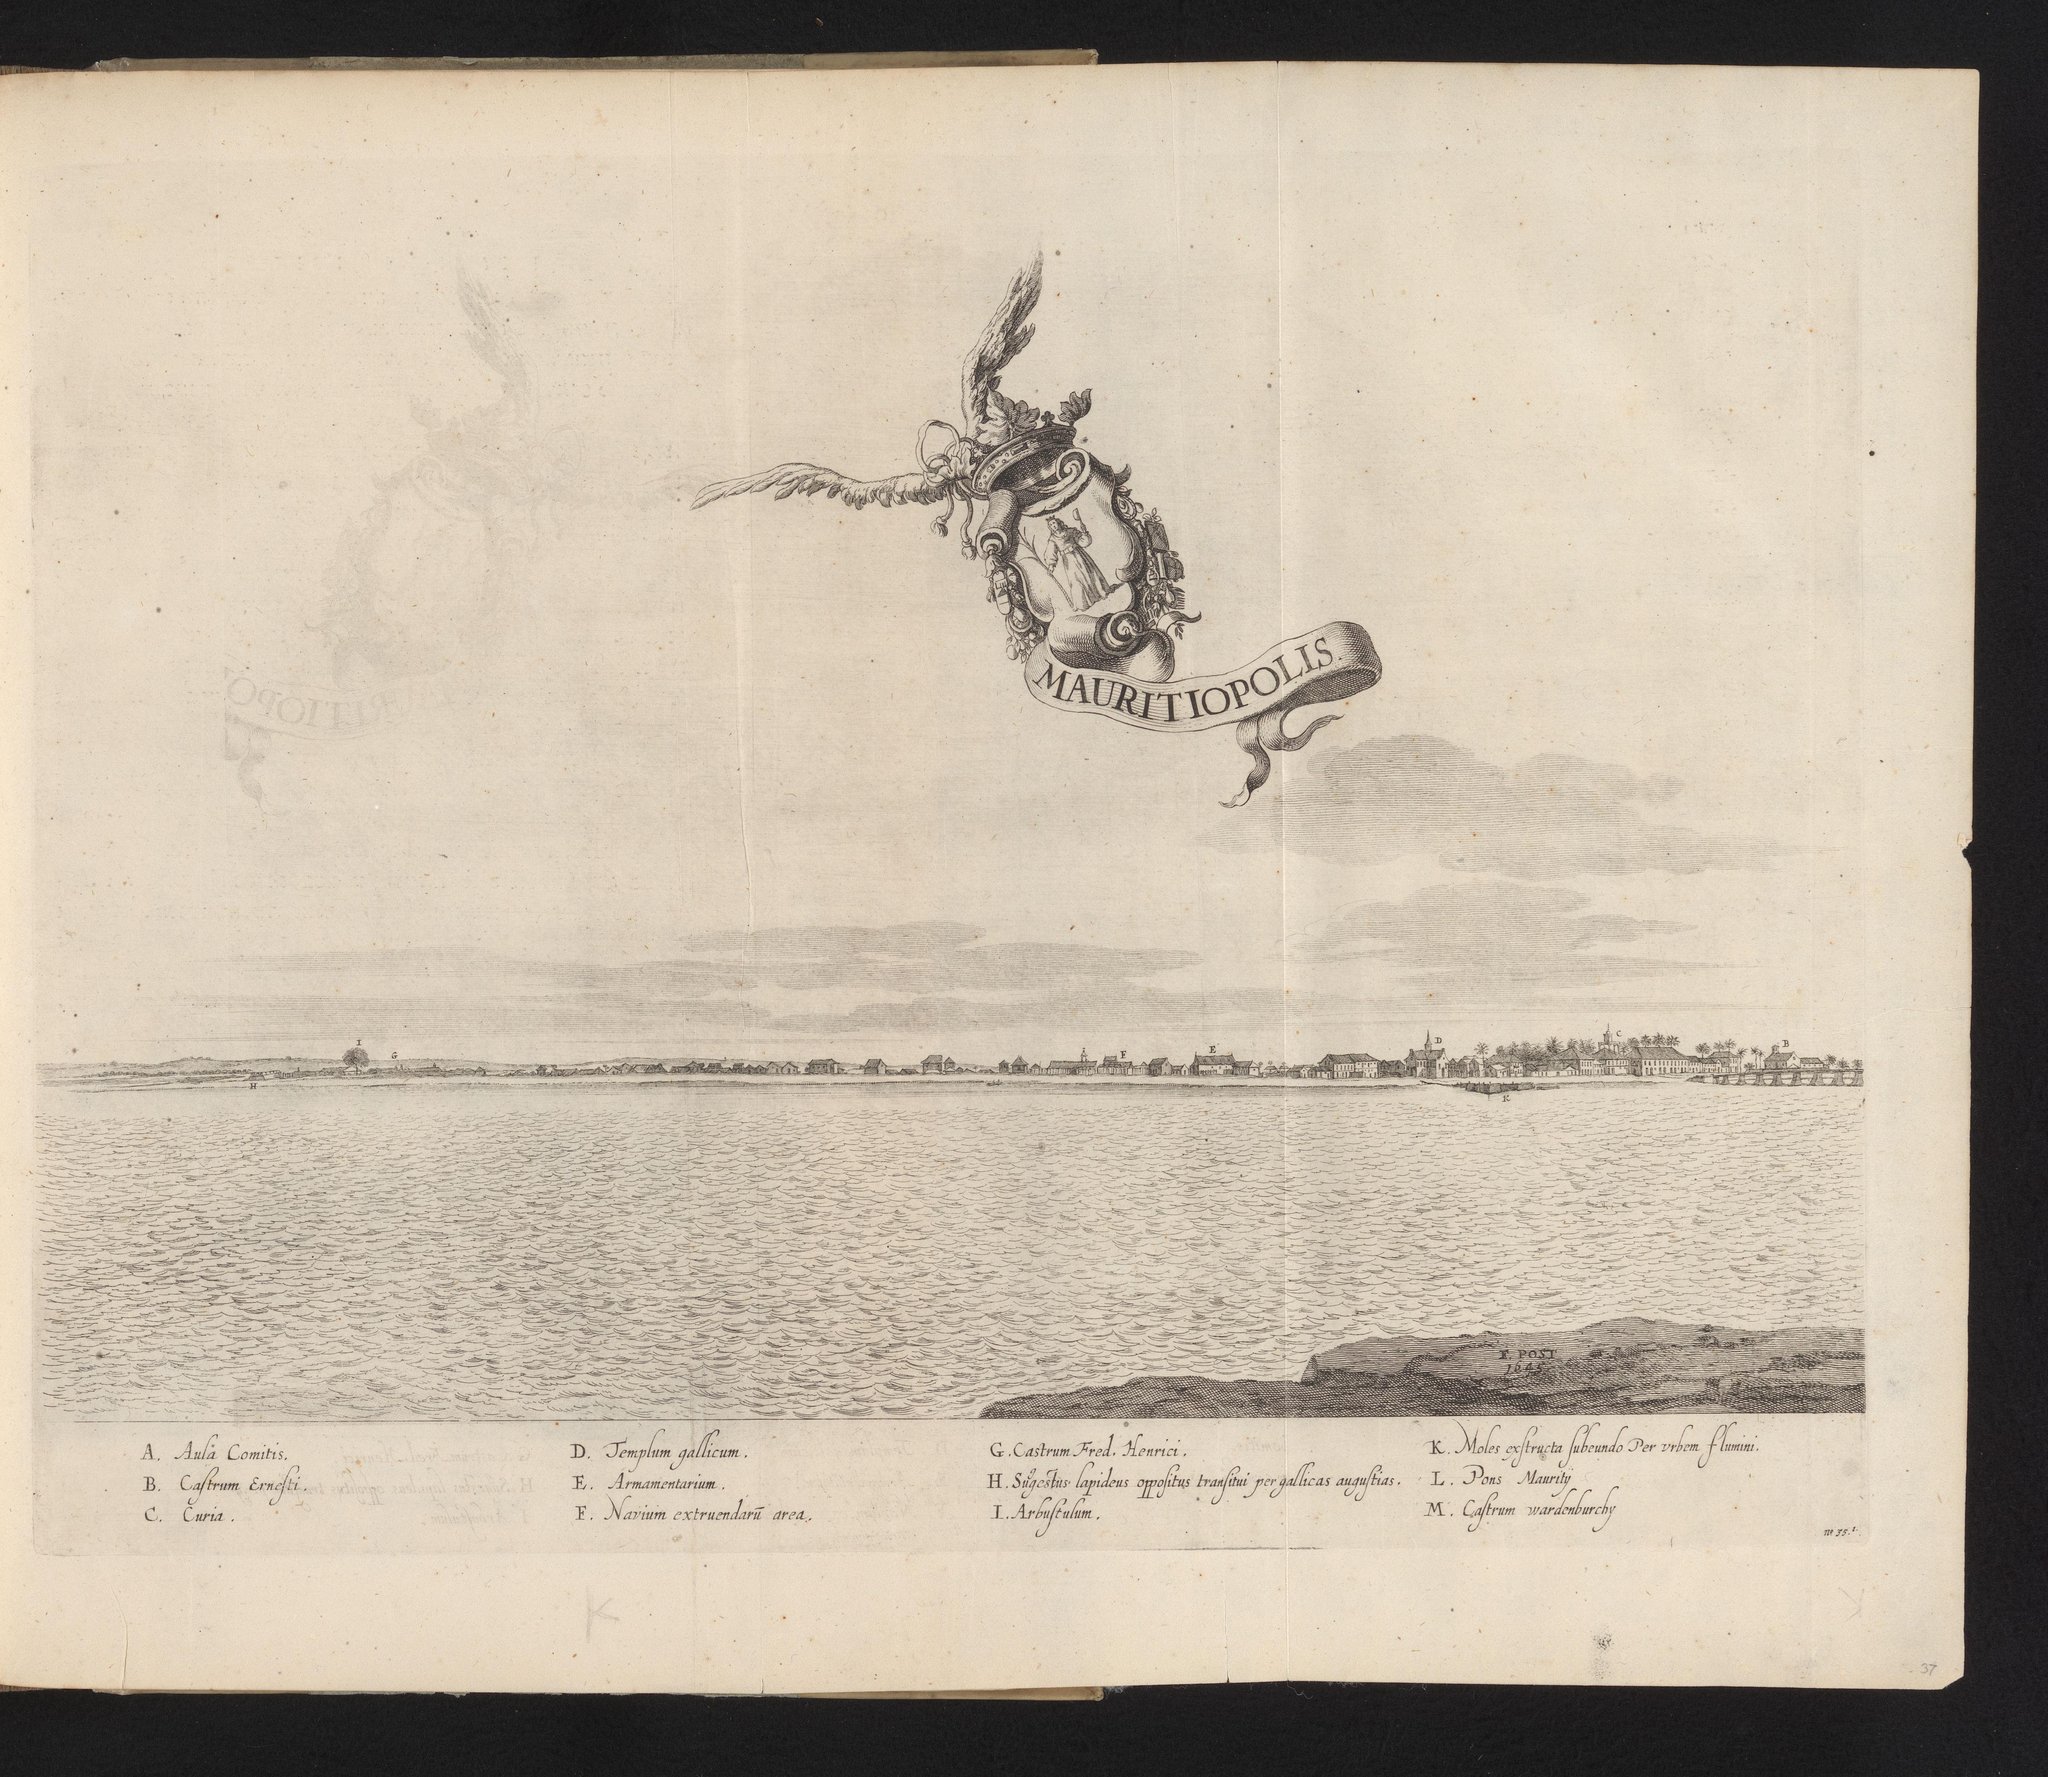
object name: print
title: Mauritiopolis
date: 1645-1647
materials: paper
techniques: engraving, etching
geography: amsterdam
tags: earl, johan maurits graaf van nassau-siegen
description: Gezicht op Mauritsstad en Recife (linkerhelft), ca. 1636-1644. Linkerhelft van een grote voorstelling gedrukt op twee bladen. In de lucht een gevleugelde banderol met de titel en een wapen waarop een staande vrouw. In het onderschrift de verklaring van de letters A-M in het Latijn. Plaat nr. 35/1 in een serie van 55 voorstellingen van de tocht naar en het verblijf in Brazilië van graaf Johan Maurits van Nassau in de jaren 1636-1644.